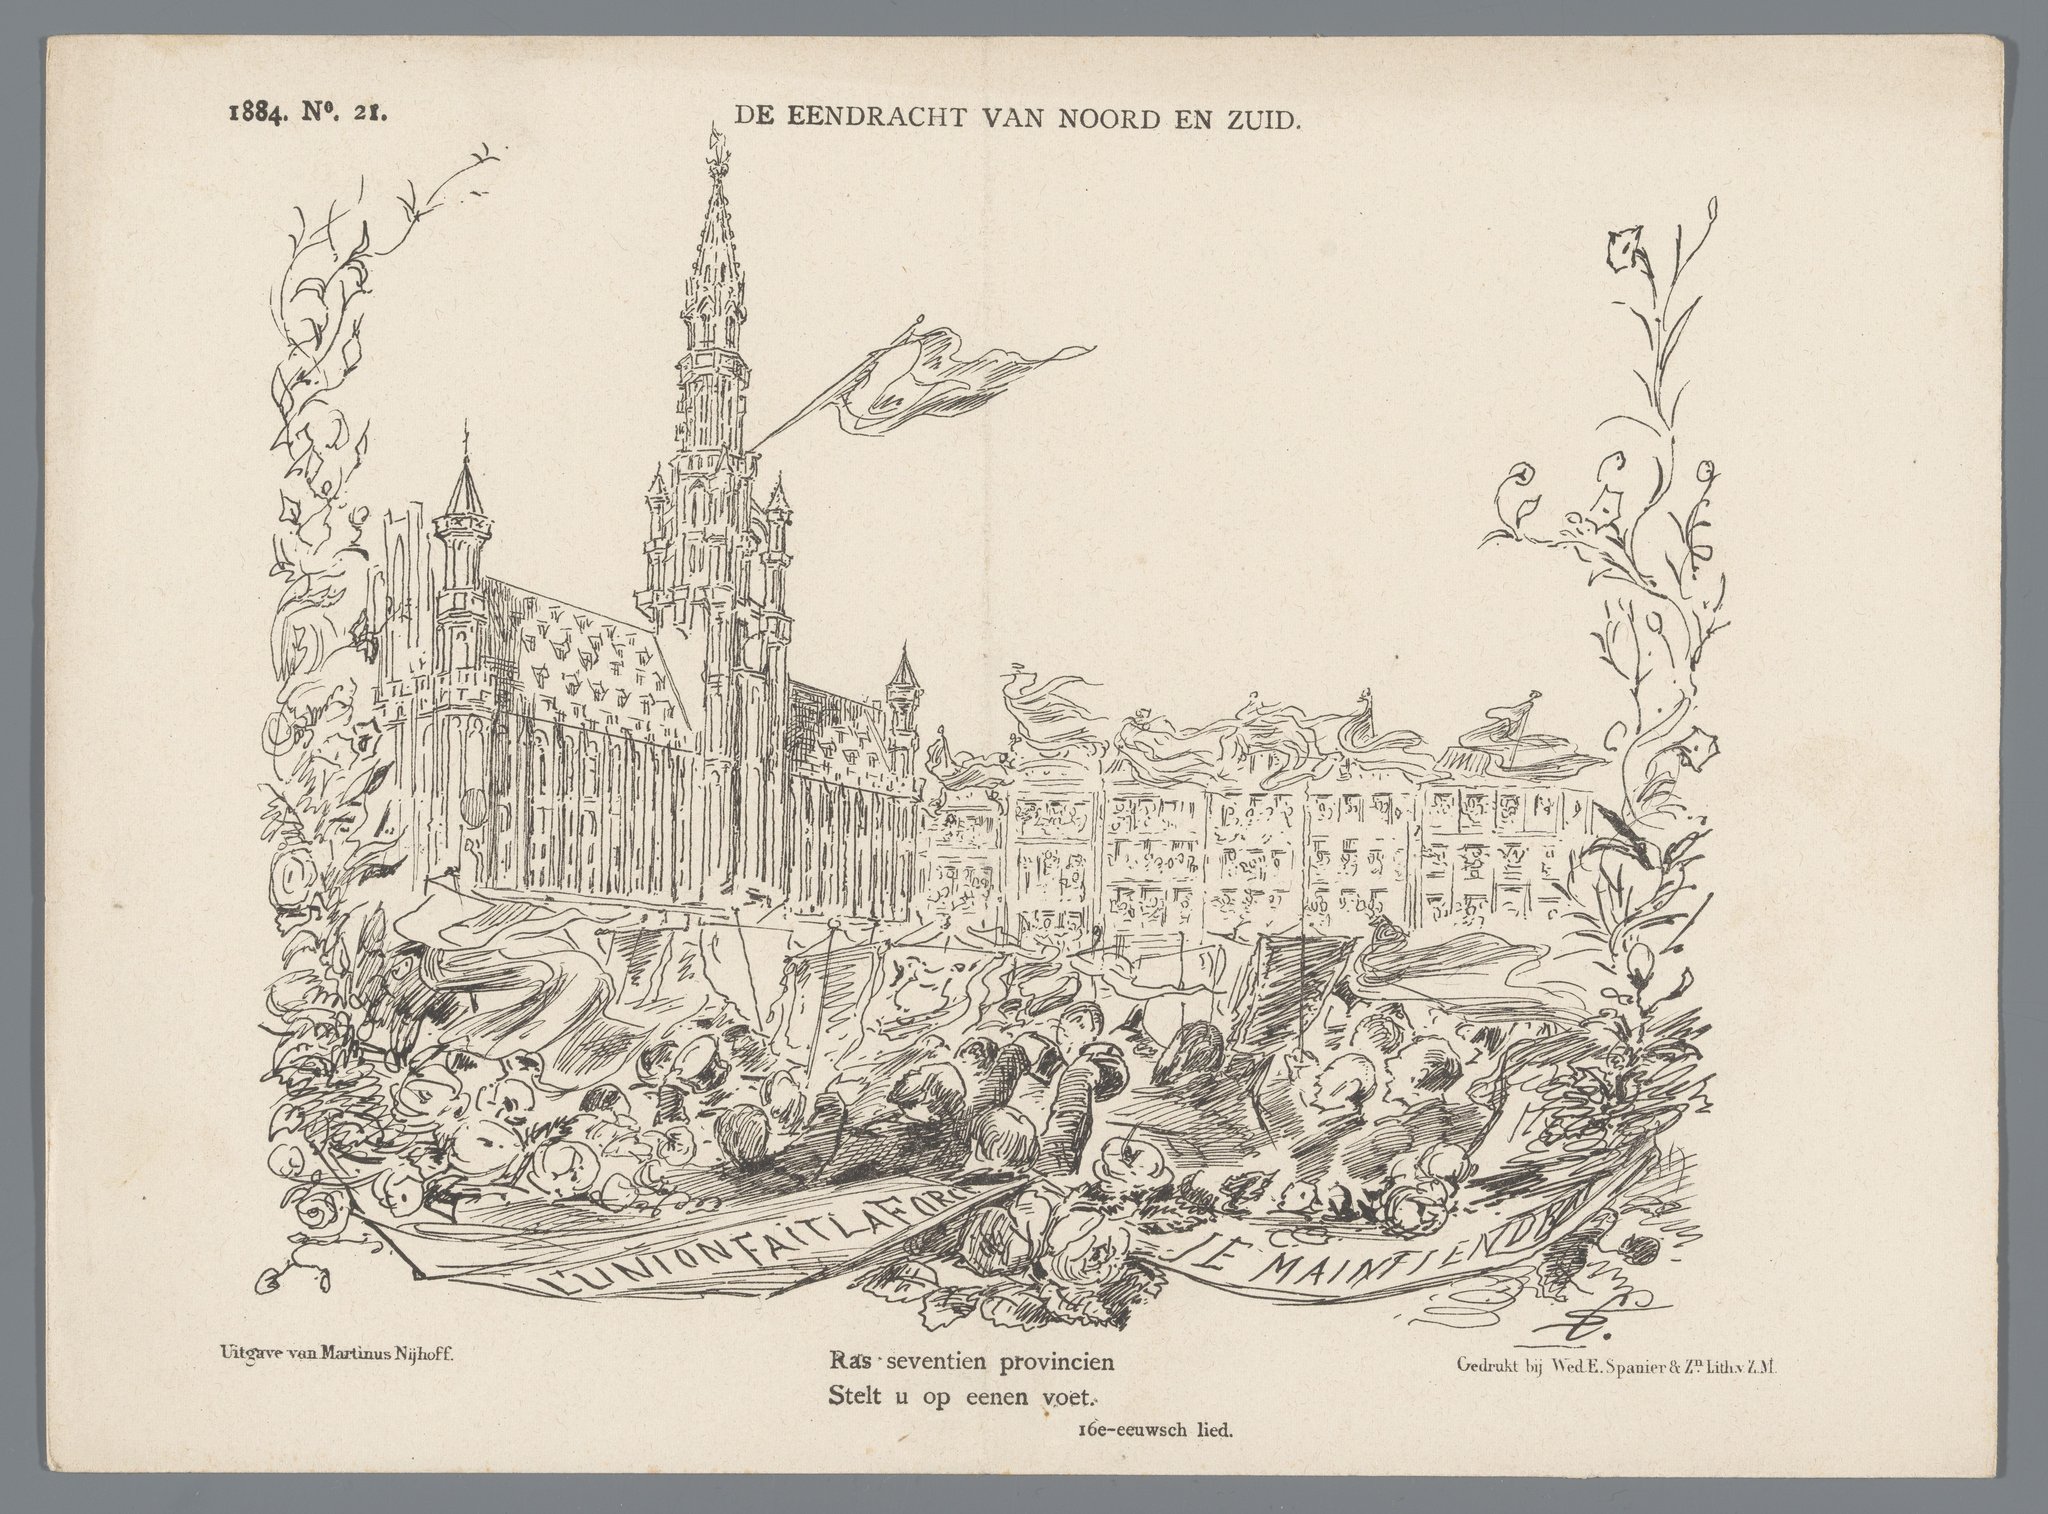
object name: cartoon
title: Spotprent over de Nederland en België, 1884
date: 1884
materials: paper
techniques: lithograph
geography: netherlands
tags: grote markt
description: Spotprent over de eendracht tussen Nederland en België: de Grote Markt van Brussel. Plaat verschenen bij het weekblad De Nederlandsche Spectator, nr. 21, 1884.